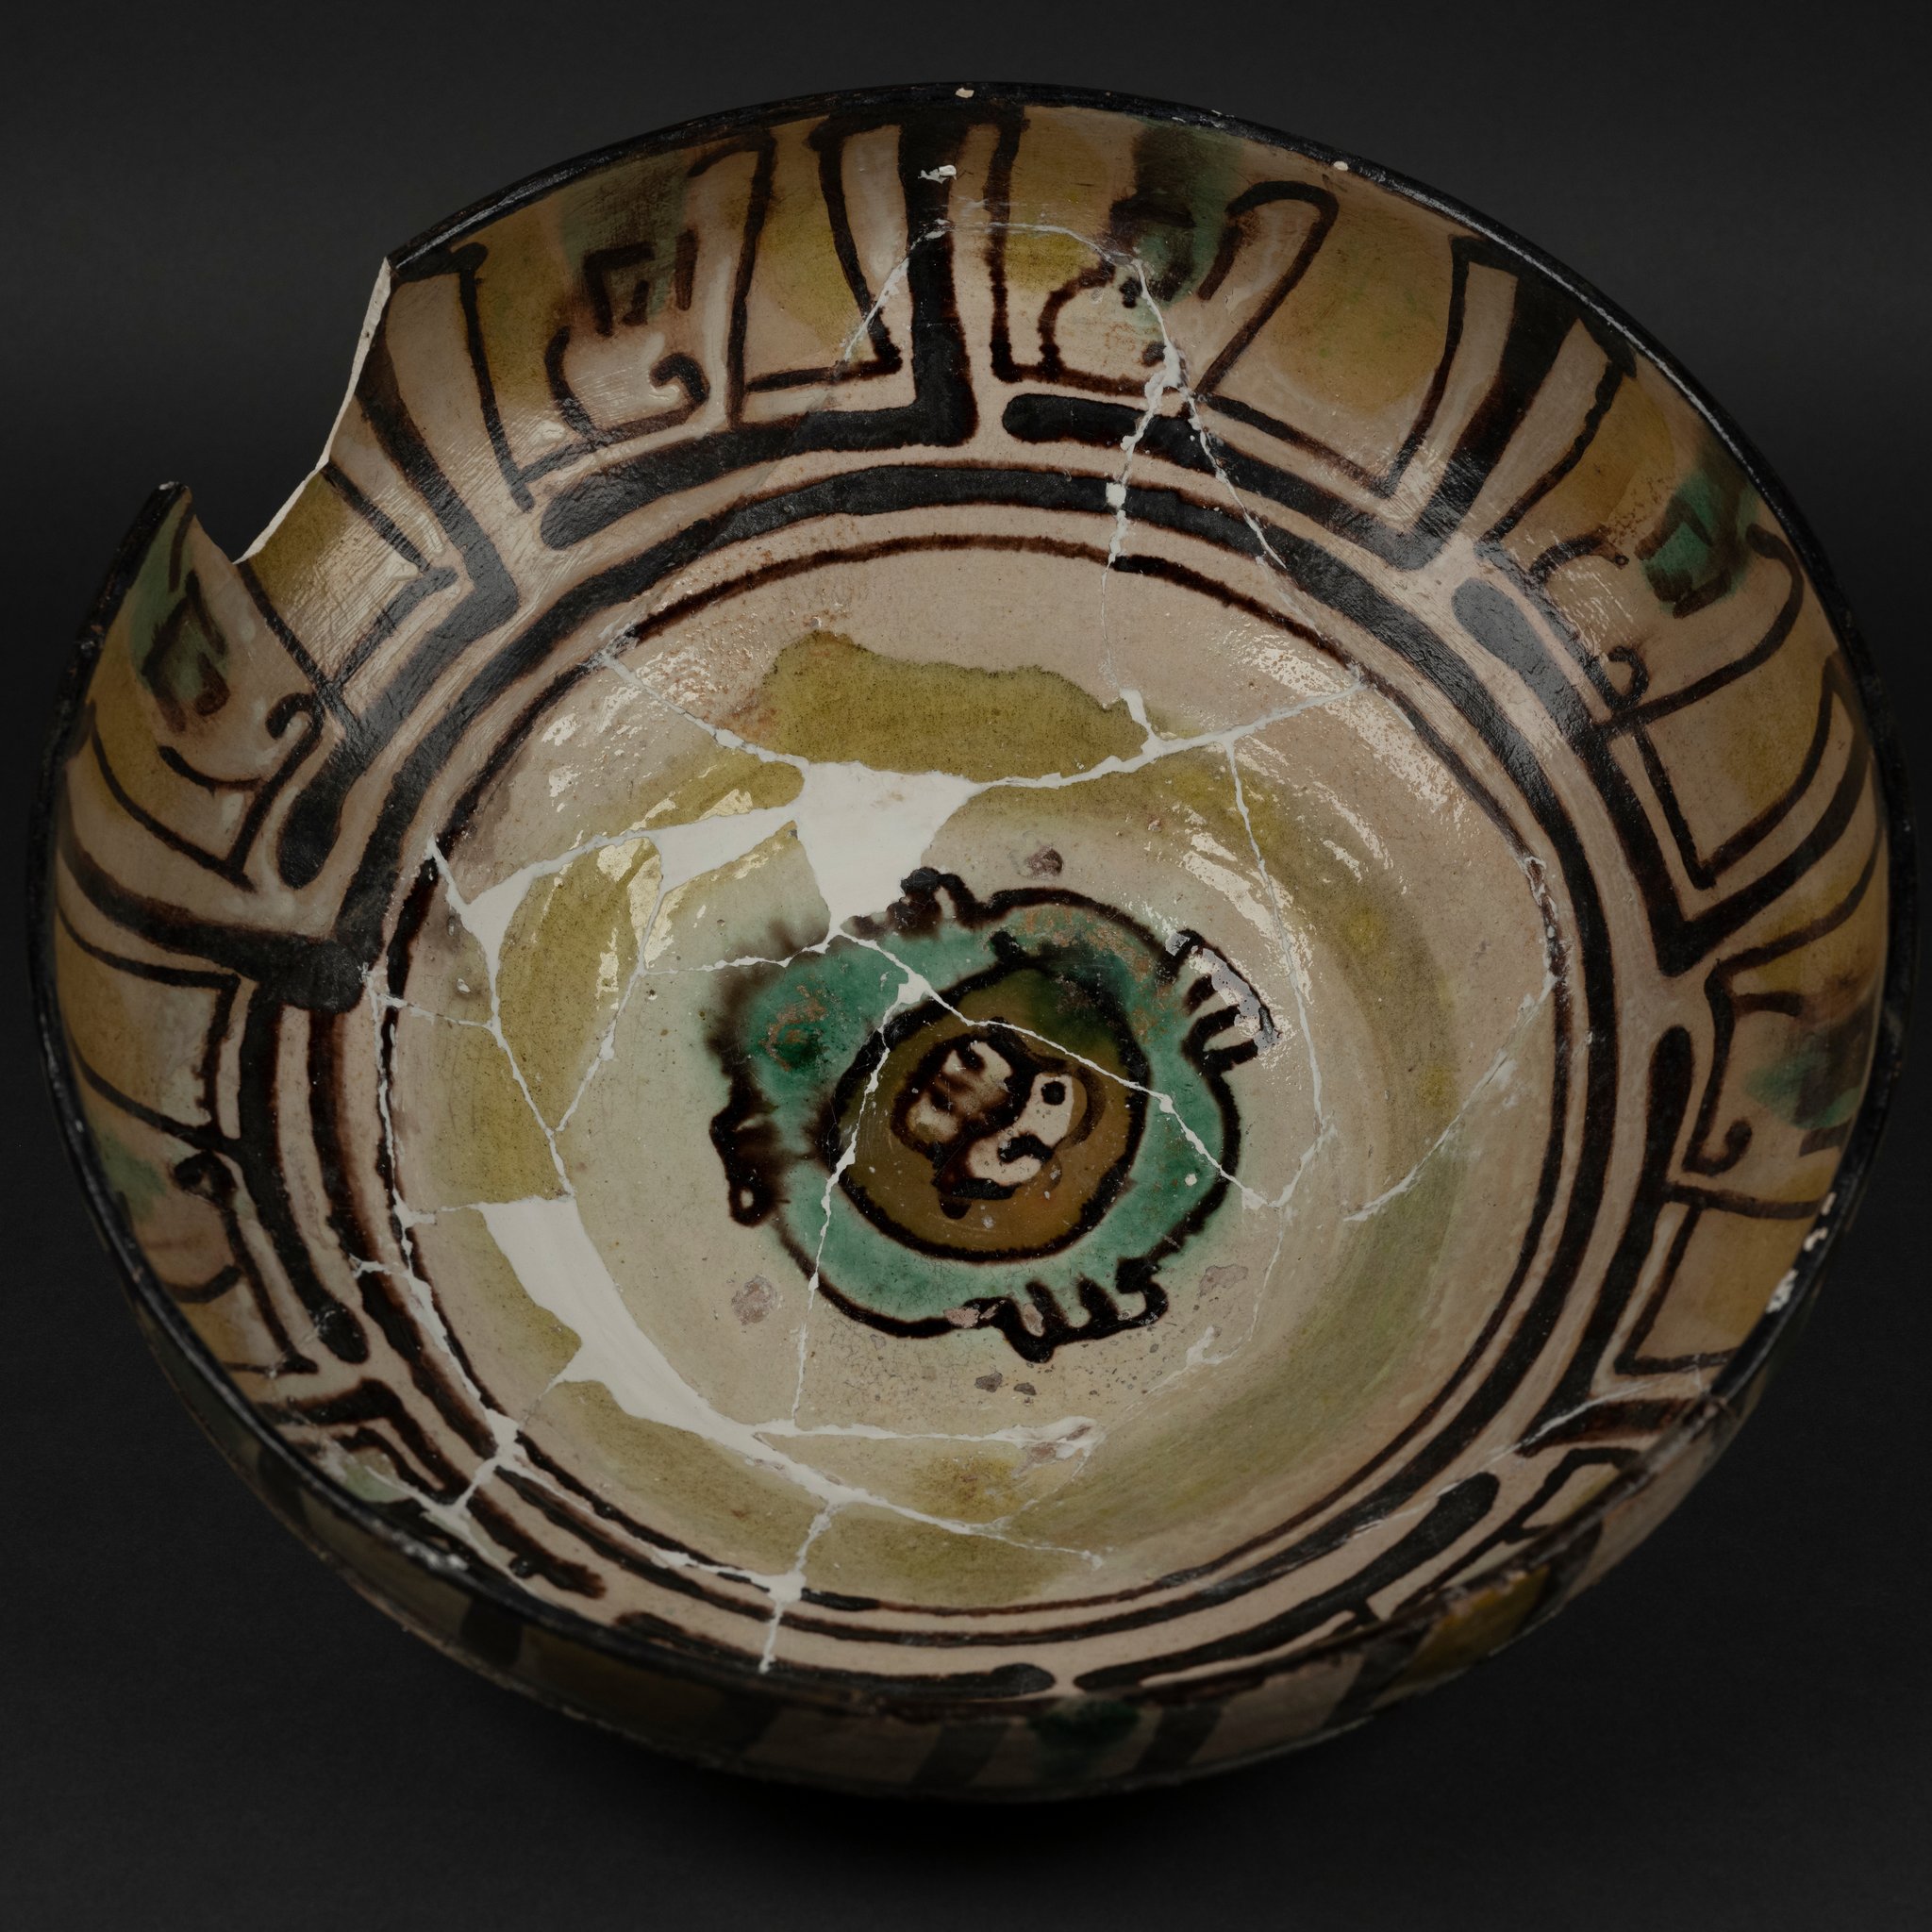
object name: bowl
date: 801-1000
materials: earthenware, glaze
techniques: painting, polychrome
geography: iran